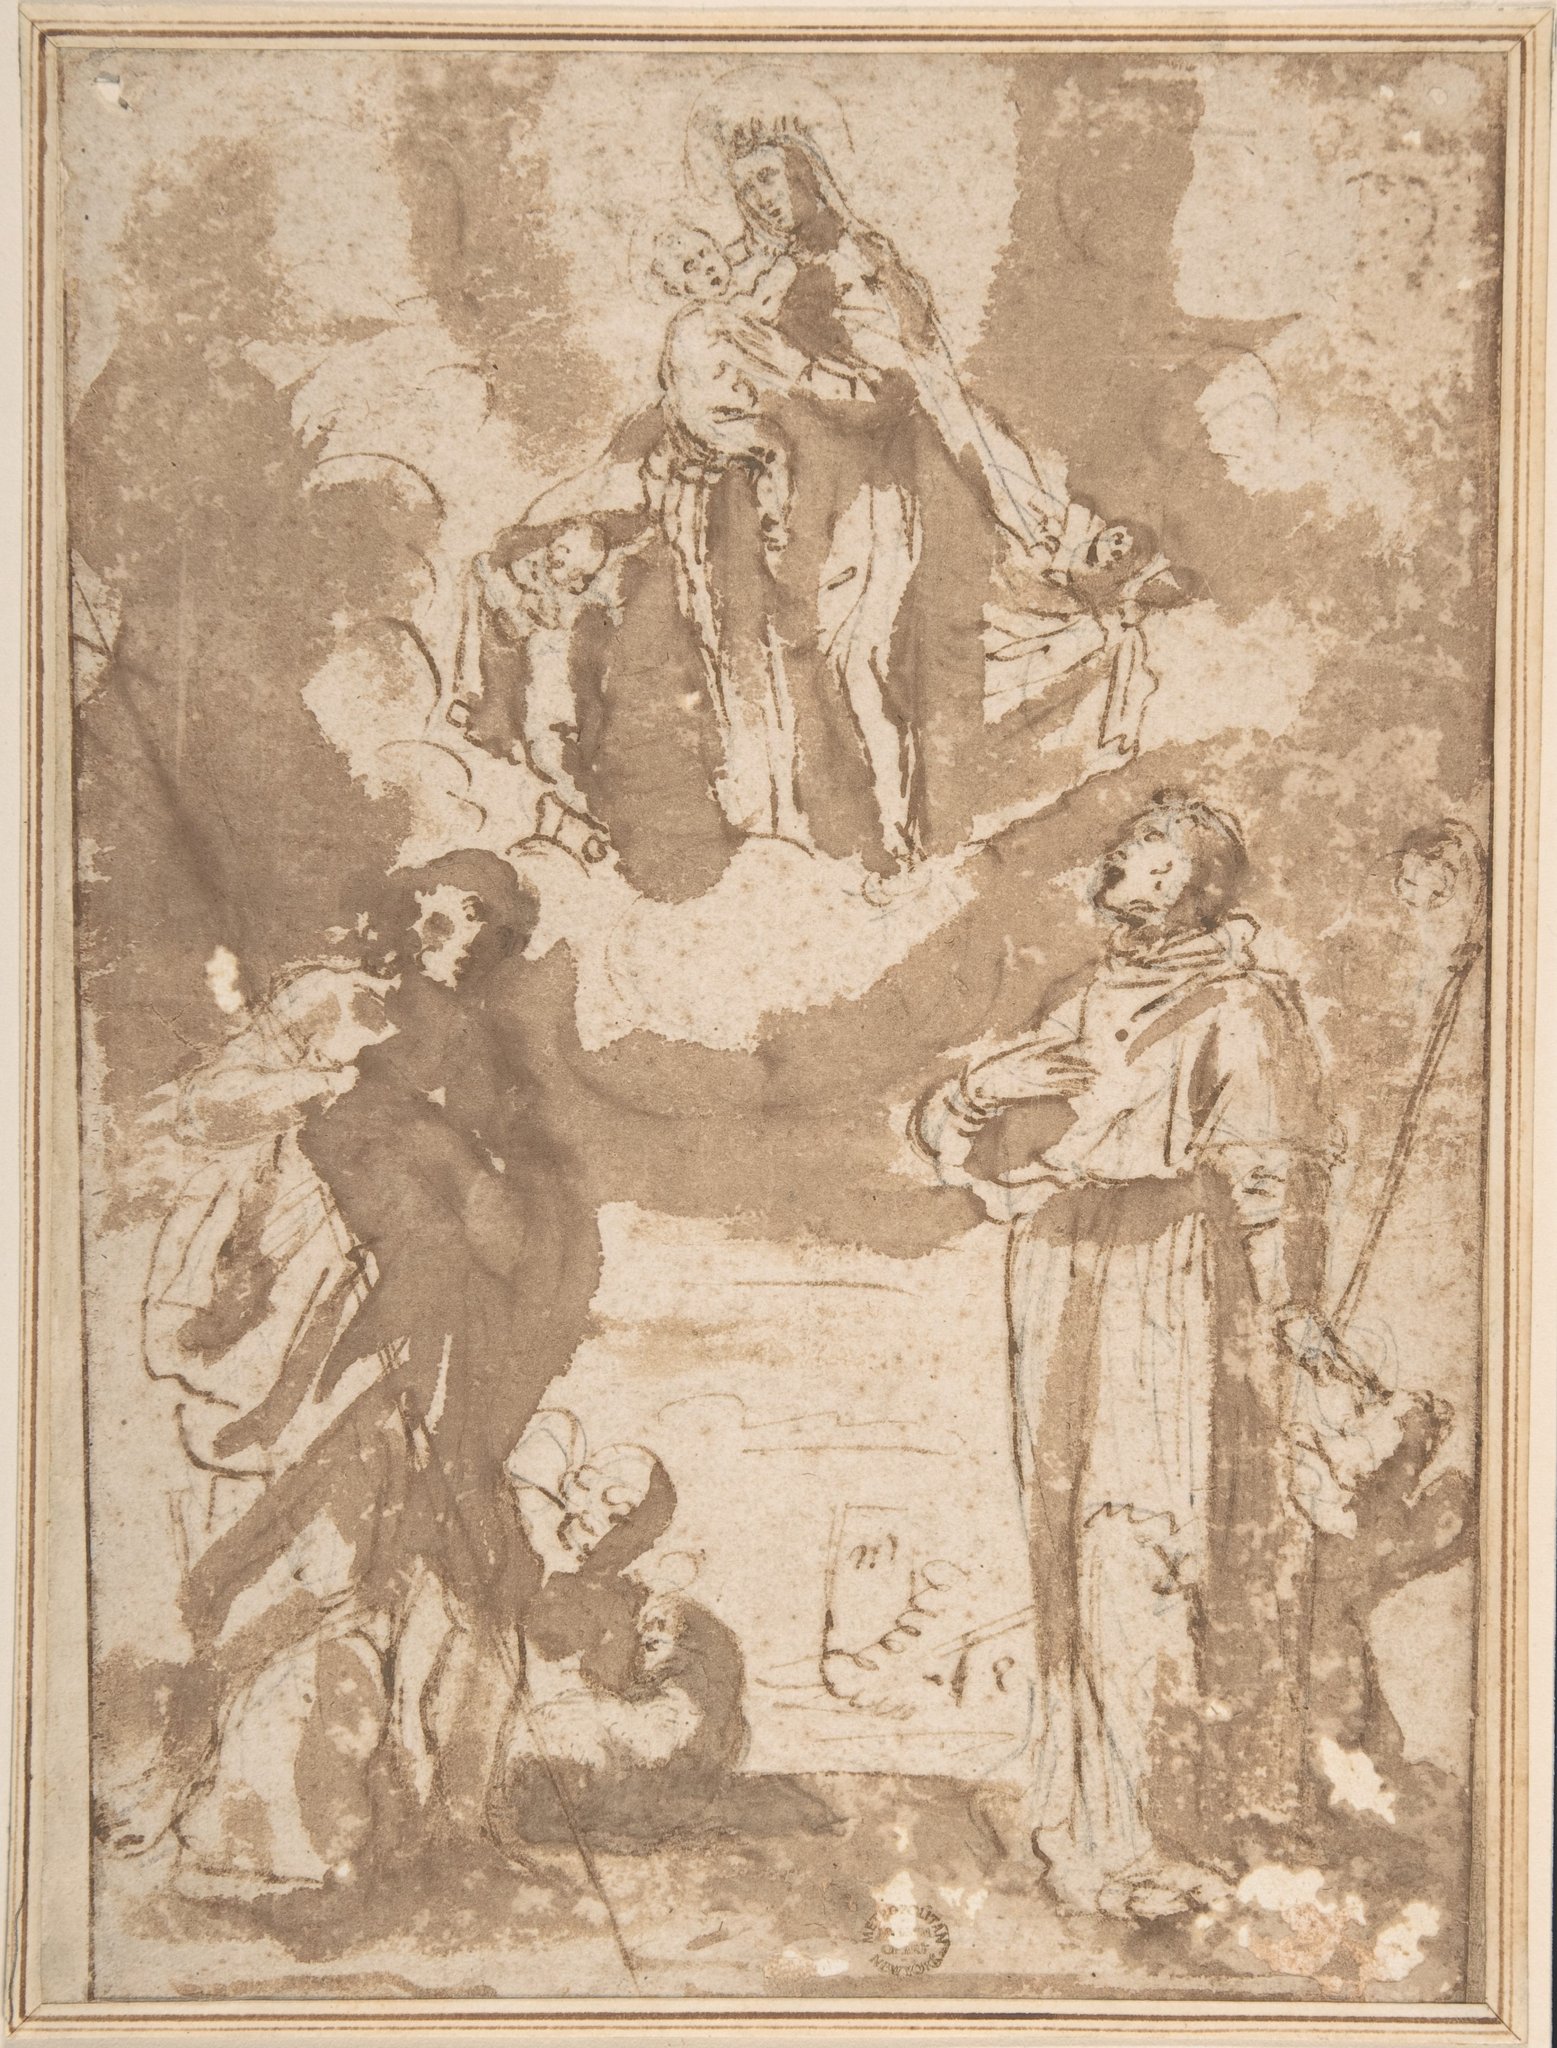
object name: drawing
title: Madonna and Child with Saints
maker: anonymous, italian, roman-bolognese, 17th century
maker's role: artist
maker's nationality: italian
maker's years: 1600-1700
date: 1601-1700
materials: charcoal, ink, paper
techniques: brush, pen, wash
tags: madonna and child,saints